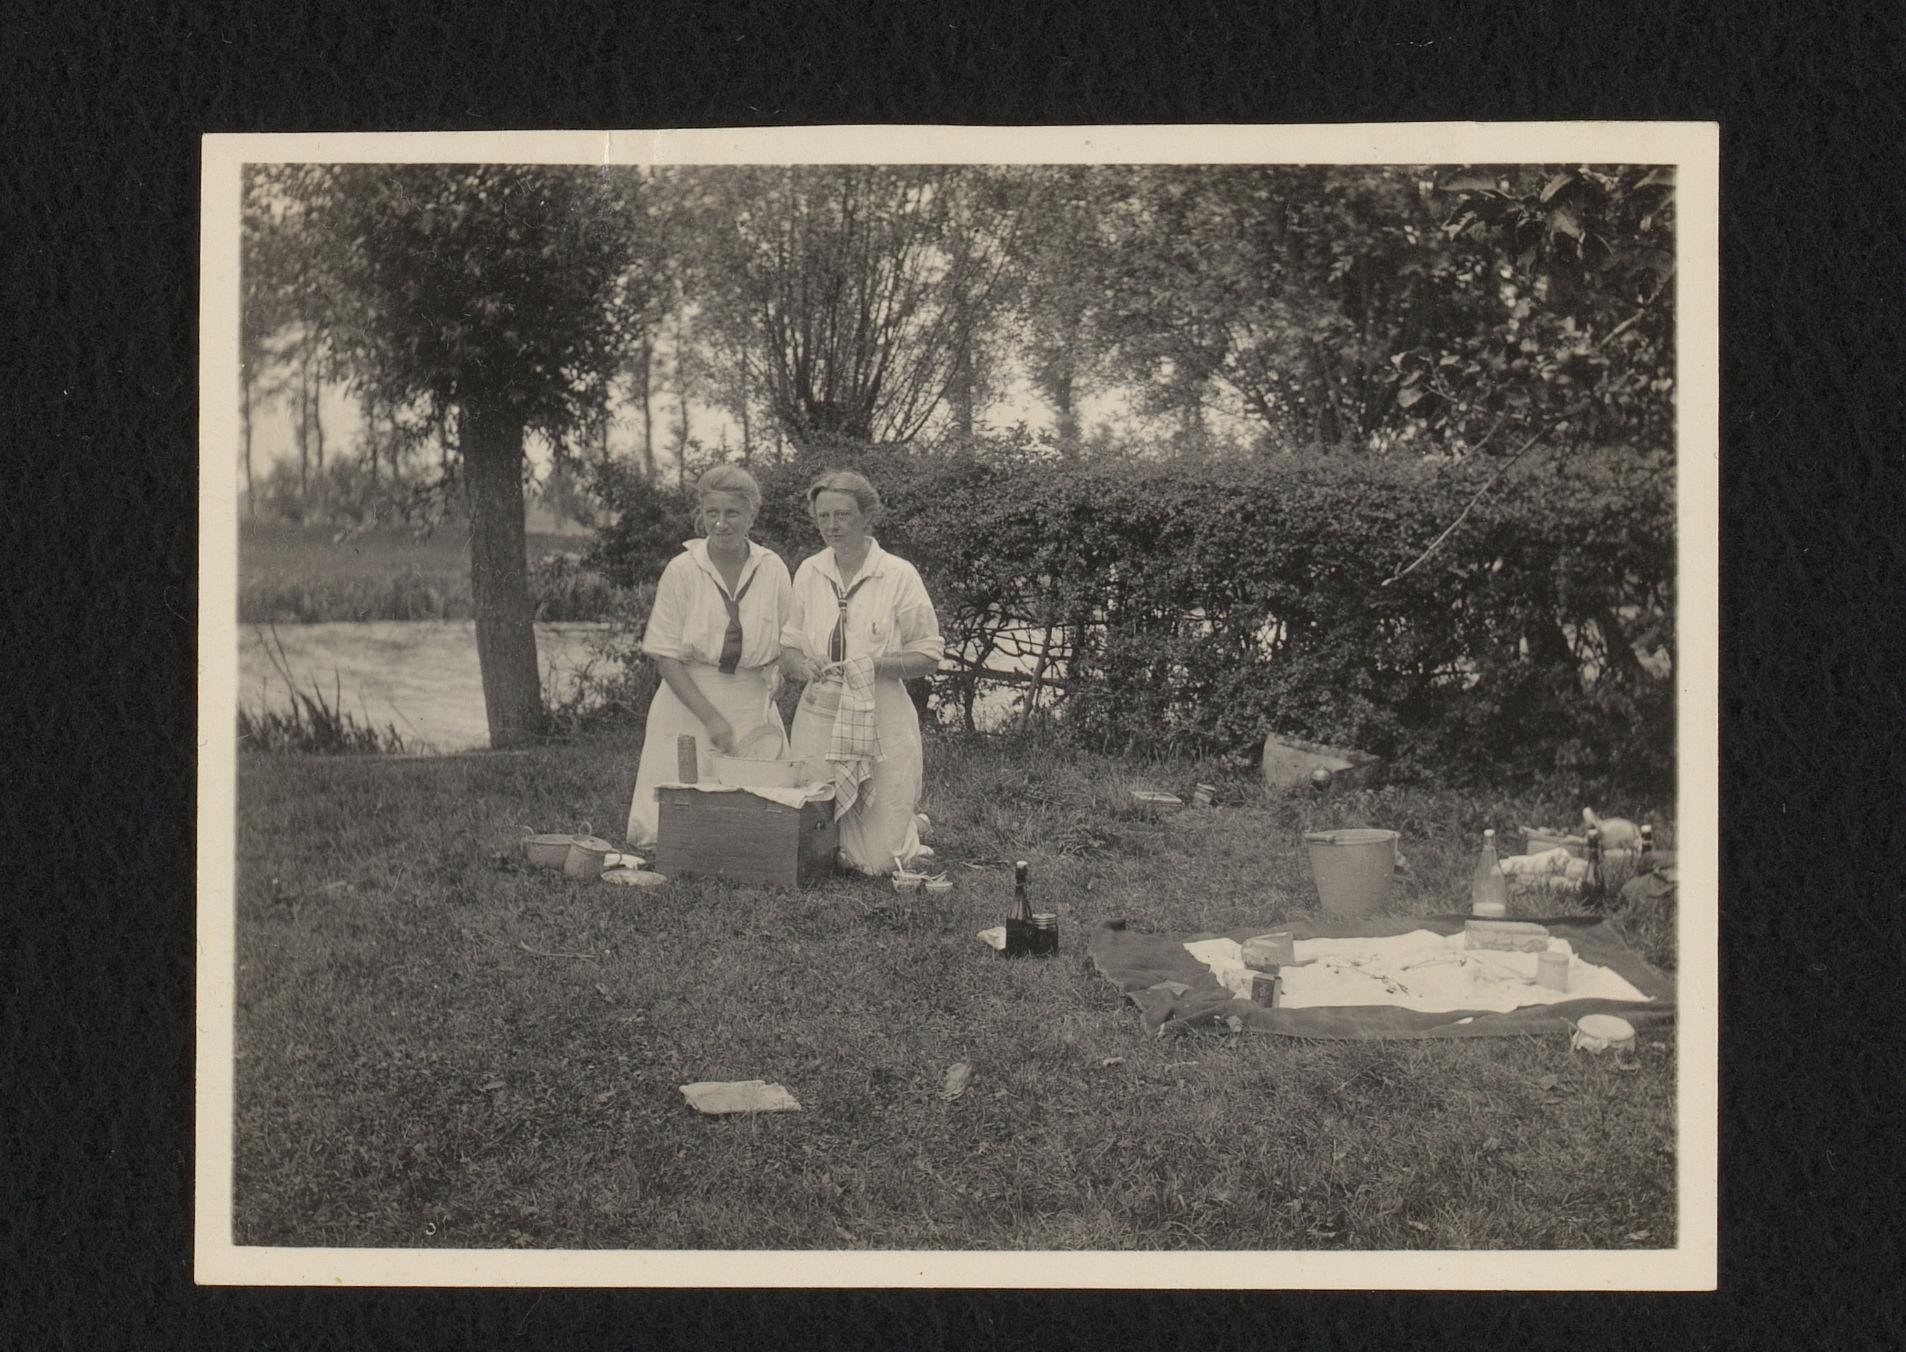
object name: photograph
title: Twee vrouwen doen de afwas in het gras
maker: Anonymous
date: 1918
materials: paper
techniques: gelatin silver print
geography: ijssel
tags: historical persons not known by name - bb - woman, cooking food - cc - in the open air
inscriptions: number: ‘54’, caption: ‘Maandag 19 Aug. 1918/ Afwasschen na de lunch/ IJsel’